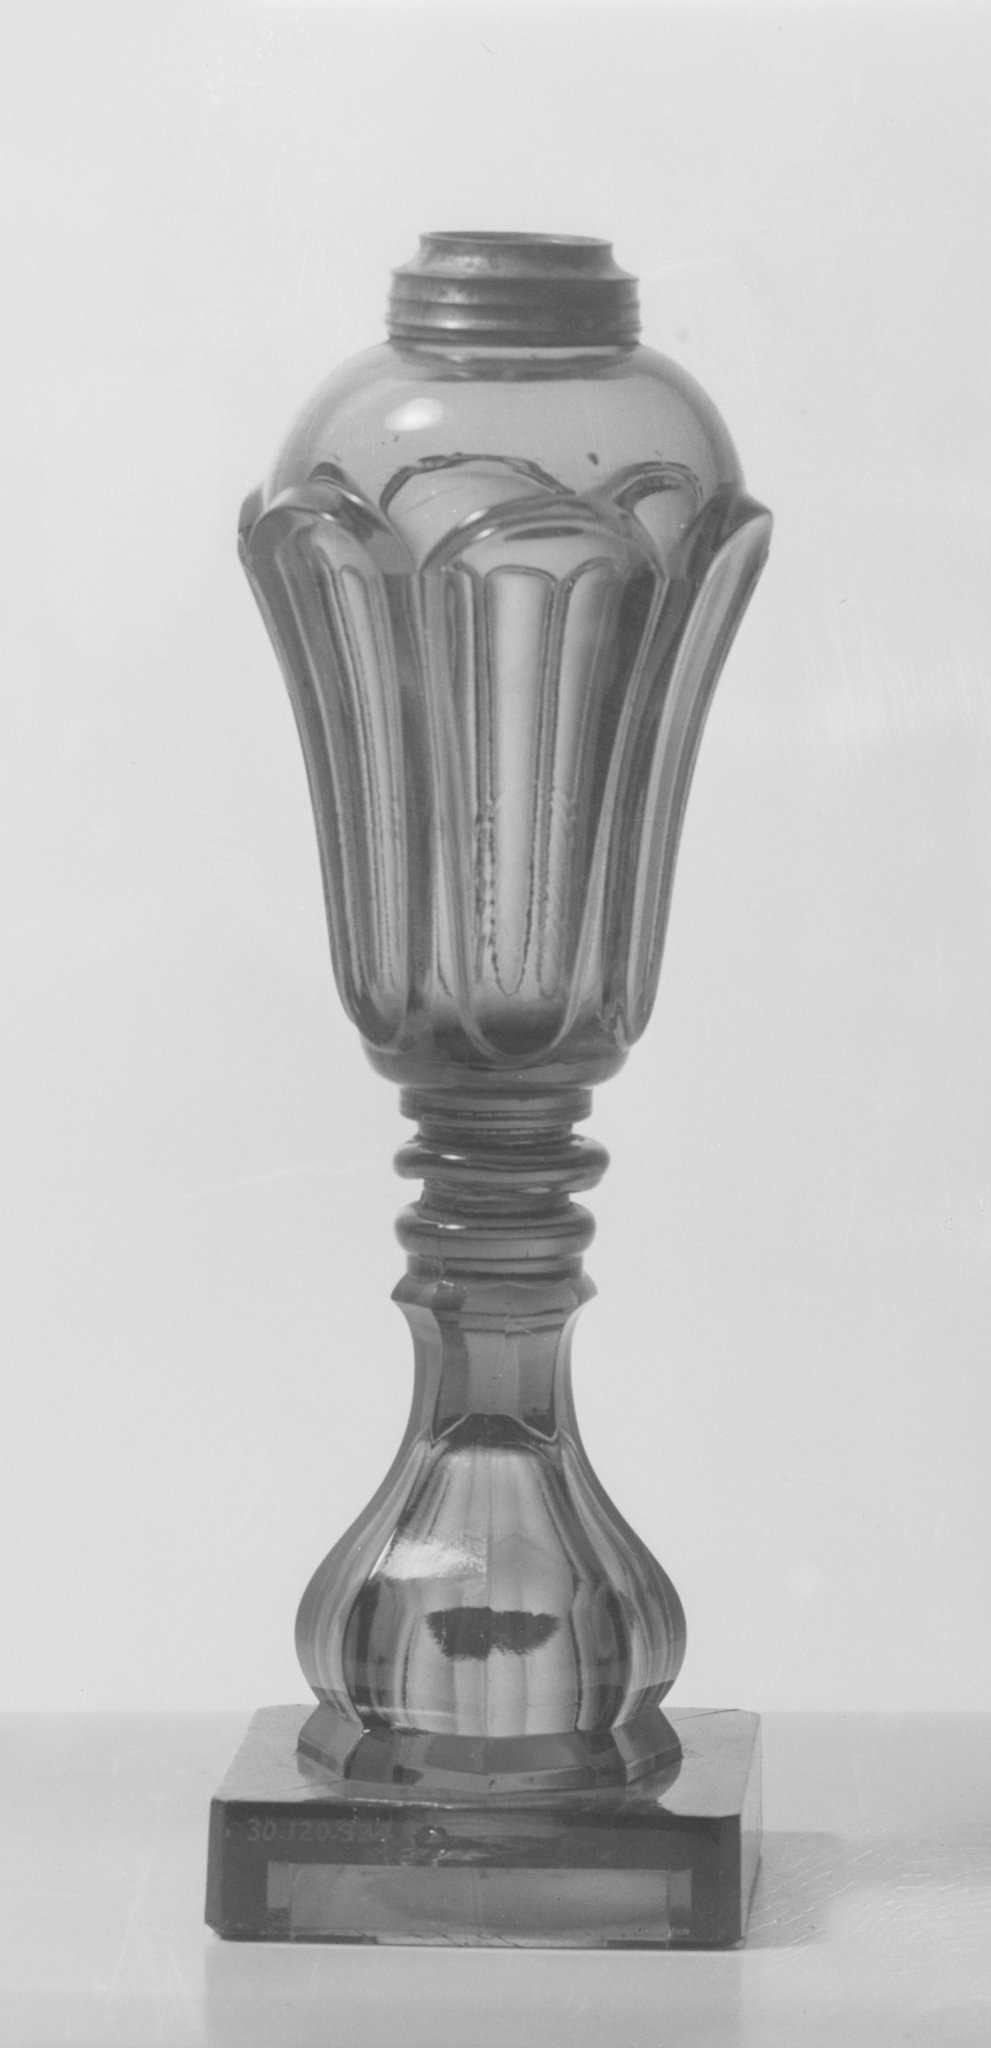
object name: lamp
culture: american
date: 1830-1870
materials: glass, metal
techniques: pressed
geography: united states